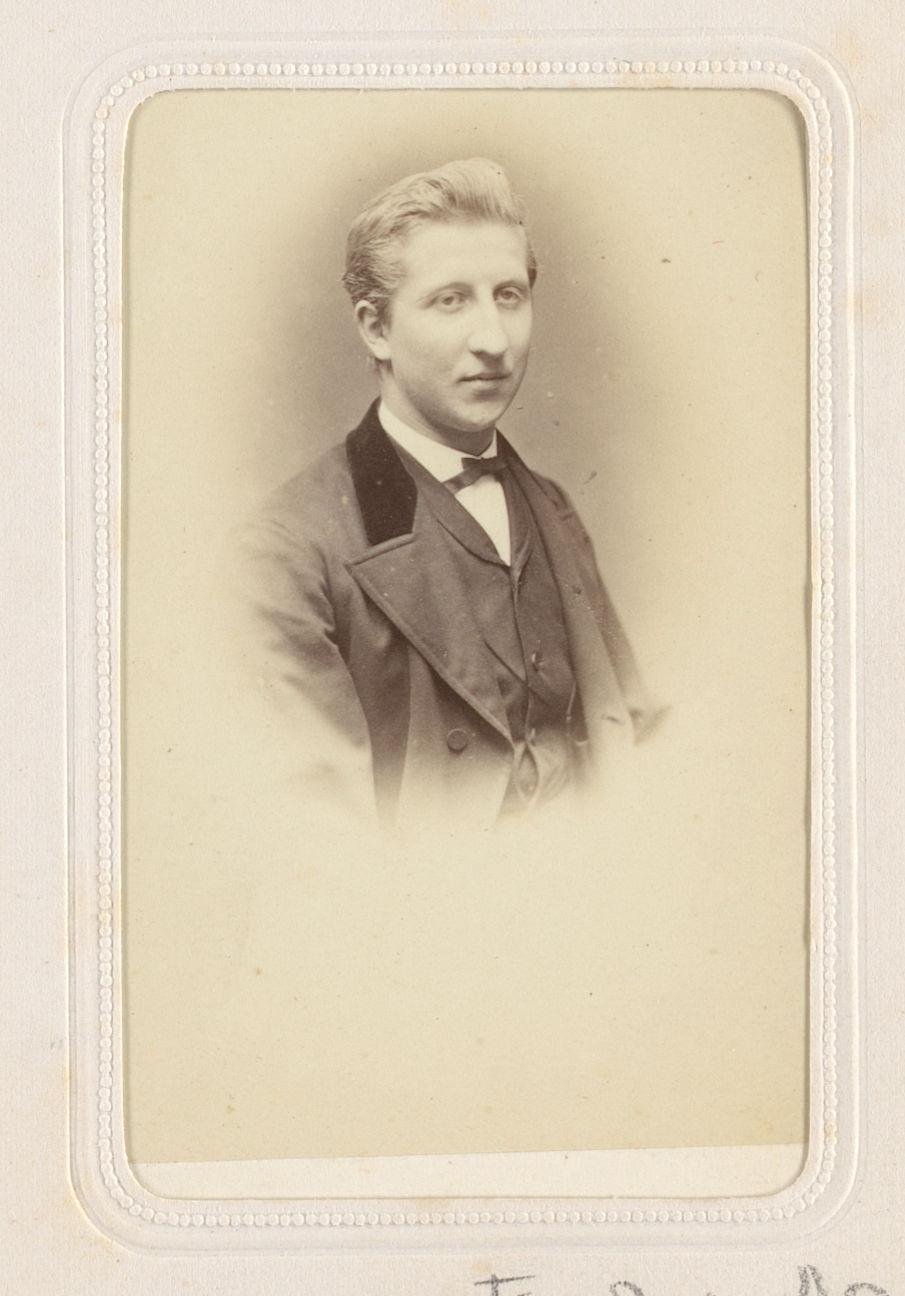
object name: photograph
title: Portret van een man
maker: albert greiner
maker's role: fotograaf, fotostudio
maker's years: 1833-1890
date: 1861-1874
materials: cardboard, photographic support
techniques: albumen print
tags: adult man, historical persons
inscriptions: inscription: ‘A. Greiner/ Photograaf/ Nieuwendijk L. 87/ Amsterdam’